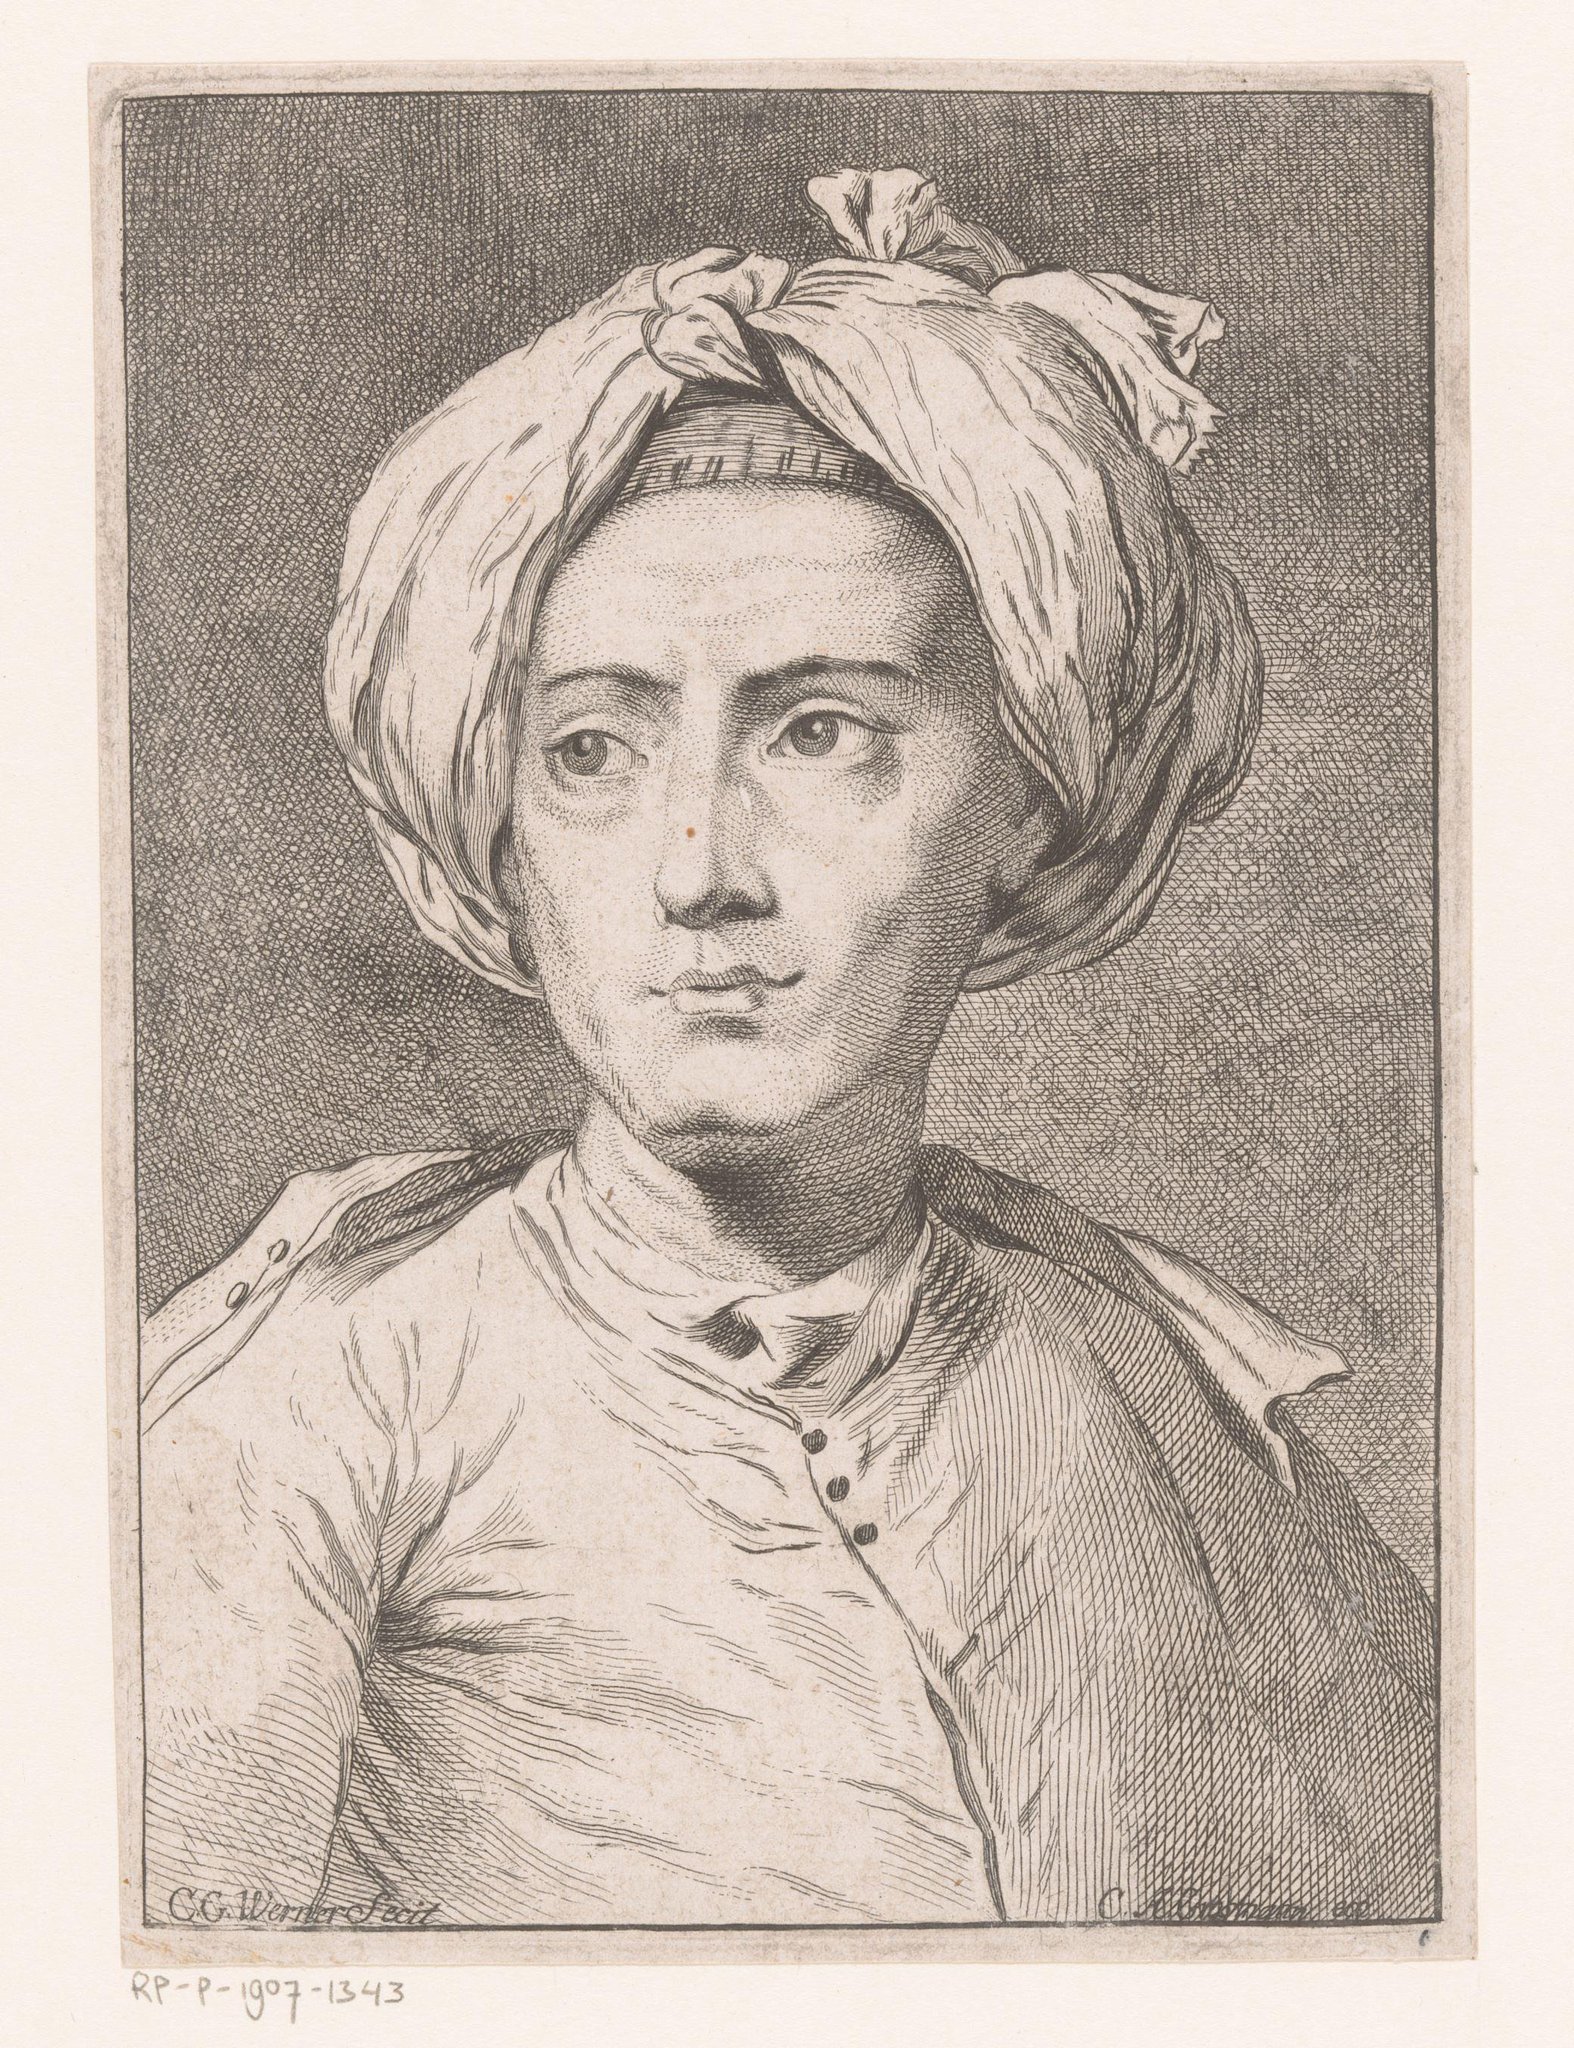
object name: print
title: Portret van een man, mogelijk een zelfportret van Christian Gottlieb Werner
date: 1755-1789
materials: paper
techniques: engraving, etching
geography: germany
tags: zwickau, print maker, christian gottlieb werner (prentmaker), head-gear, historical persons, portrait, self-portrait of artist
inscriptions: collector's mark: Lugt 2228